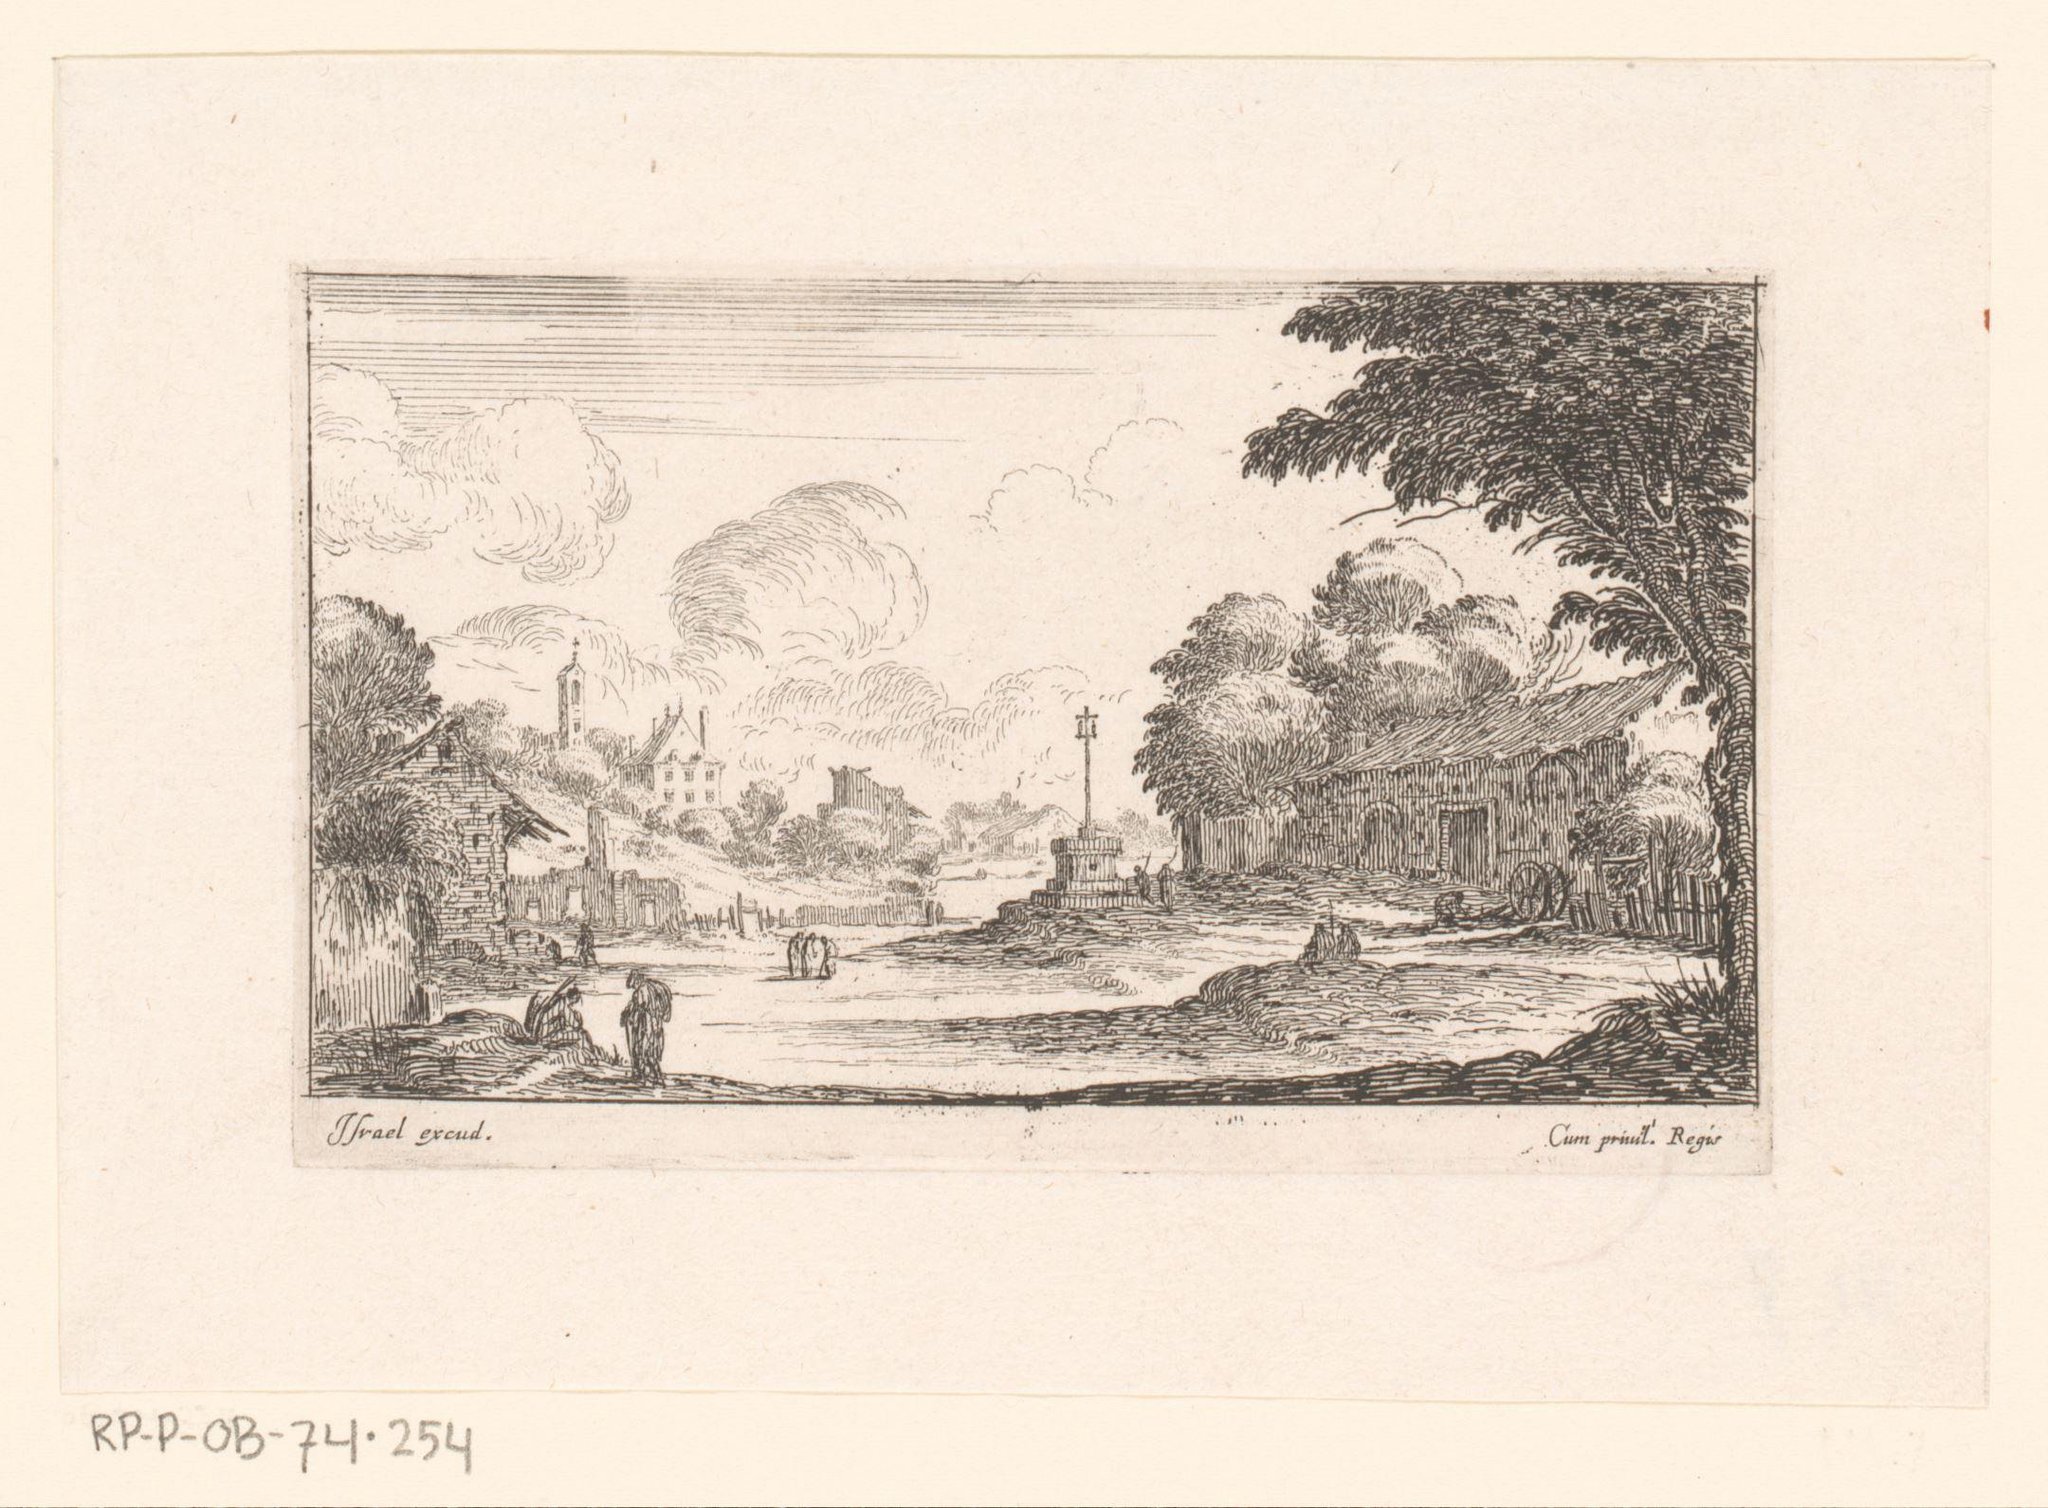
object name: print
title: Dorpsgezicht met kruis op verhoging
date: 1631-1661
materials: paper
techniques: etching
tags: landscapes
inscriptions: collector's mark: Lugt 240